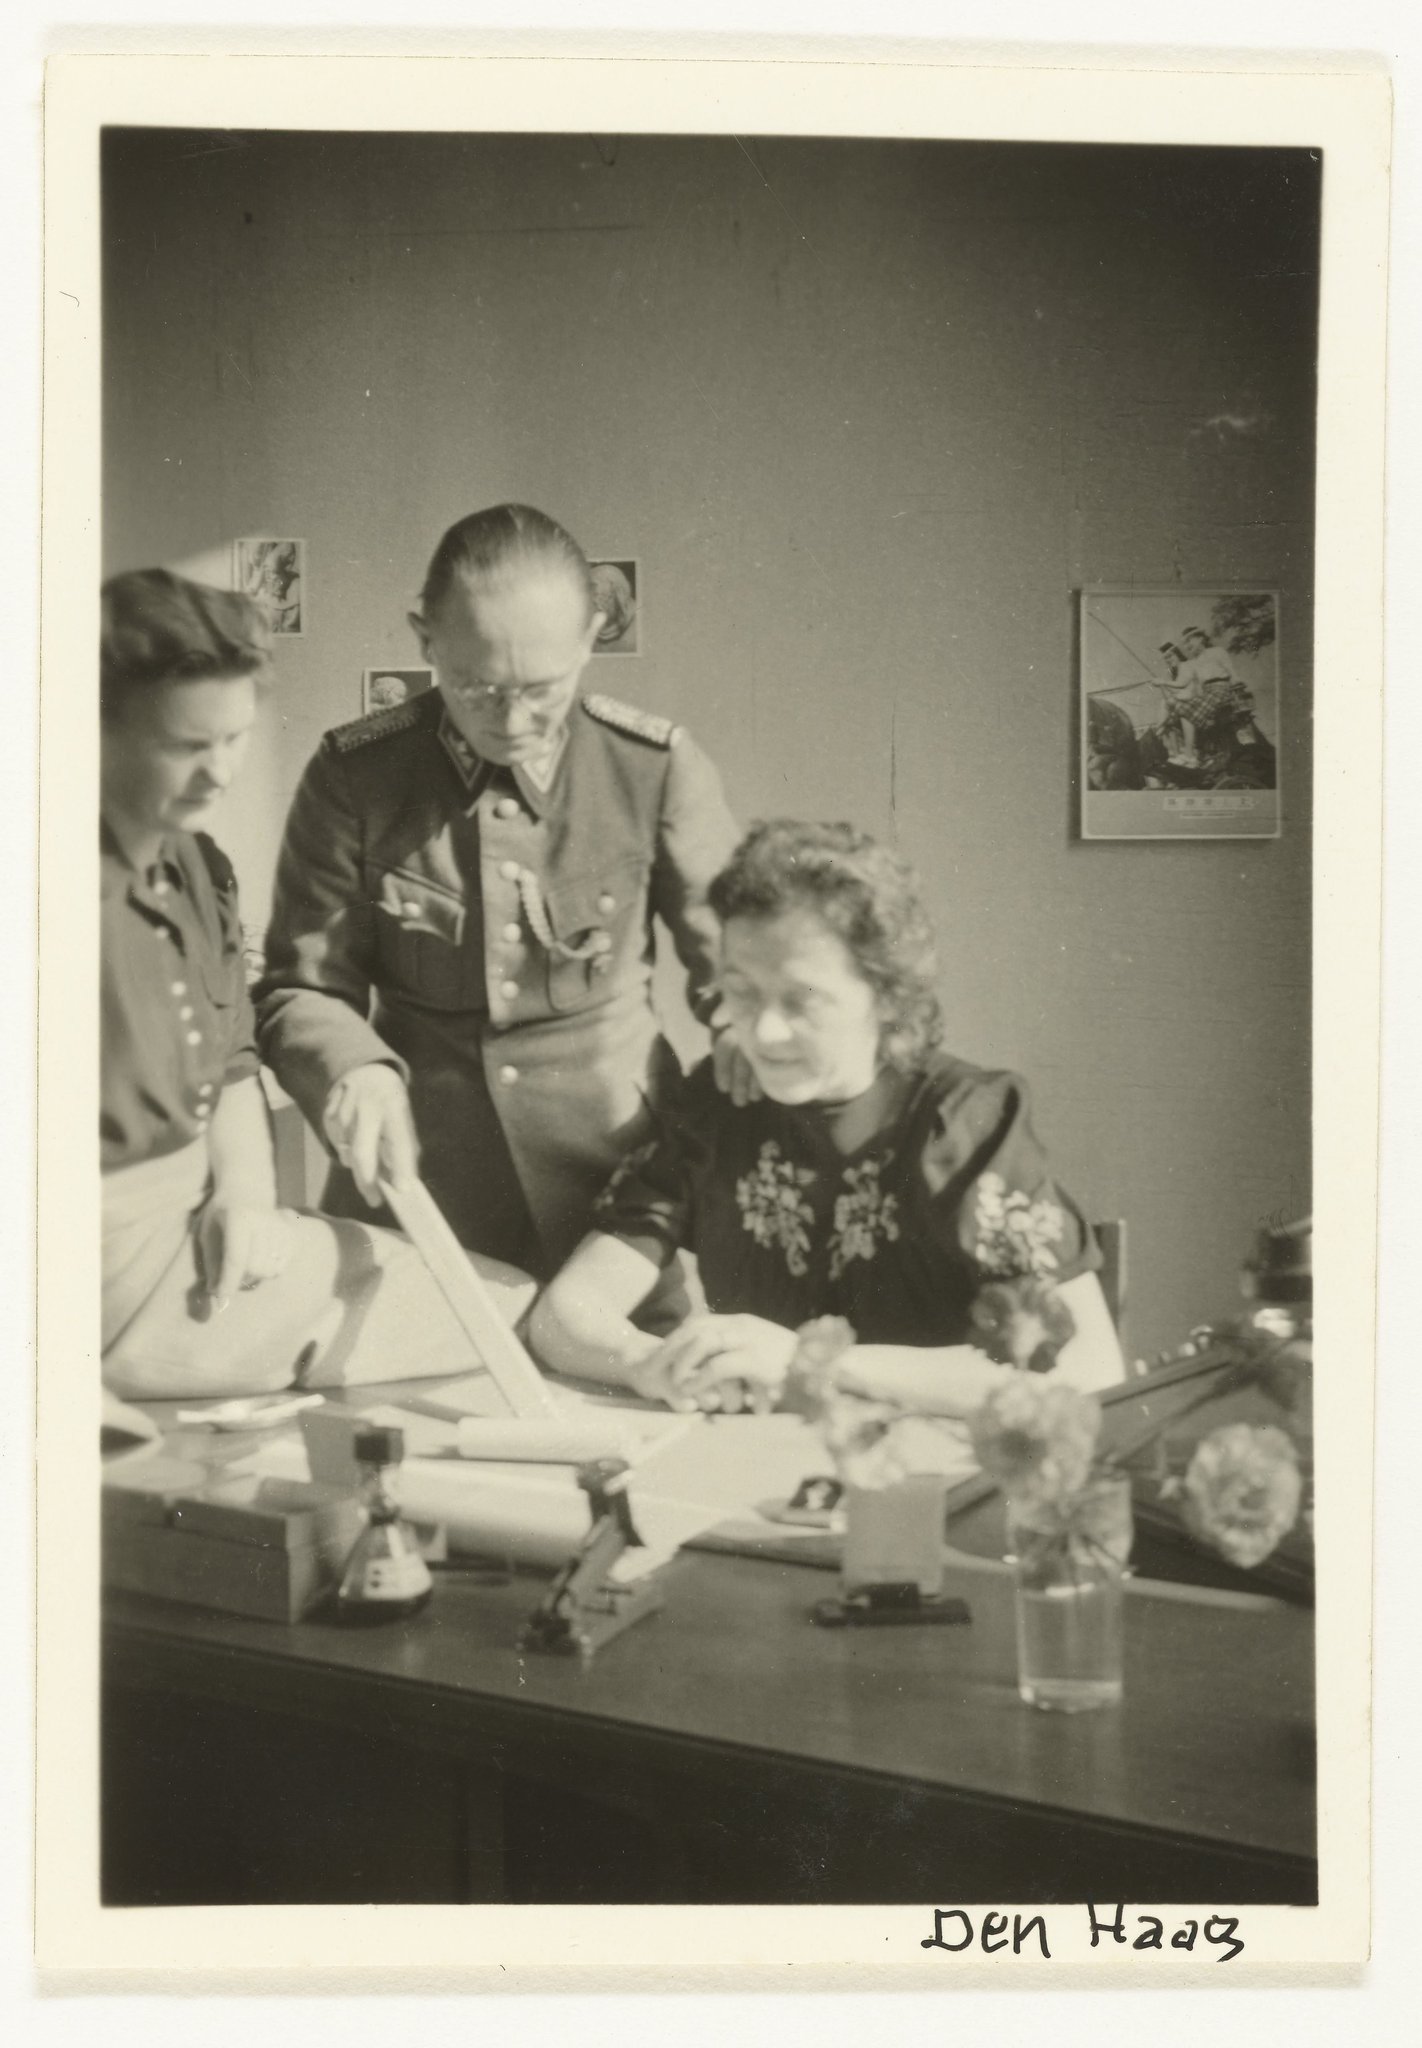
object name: photograph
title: Wehrmacht soldaat met twee Nederlandse vrouwen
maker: Anonymous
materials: photographic support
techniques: gelatin silver print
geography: the hague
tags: occupier and civilians, occupation ~ war, the hague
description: Twee Nederlandse vrouw poseren met een Duitse militair in een kamer. De linker vrouw zit half op een tafel, de militair wijst iets aan, de tweede vrouw zit aan tafel met papieren er op. Achterop staat: bei Frie.